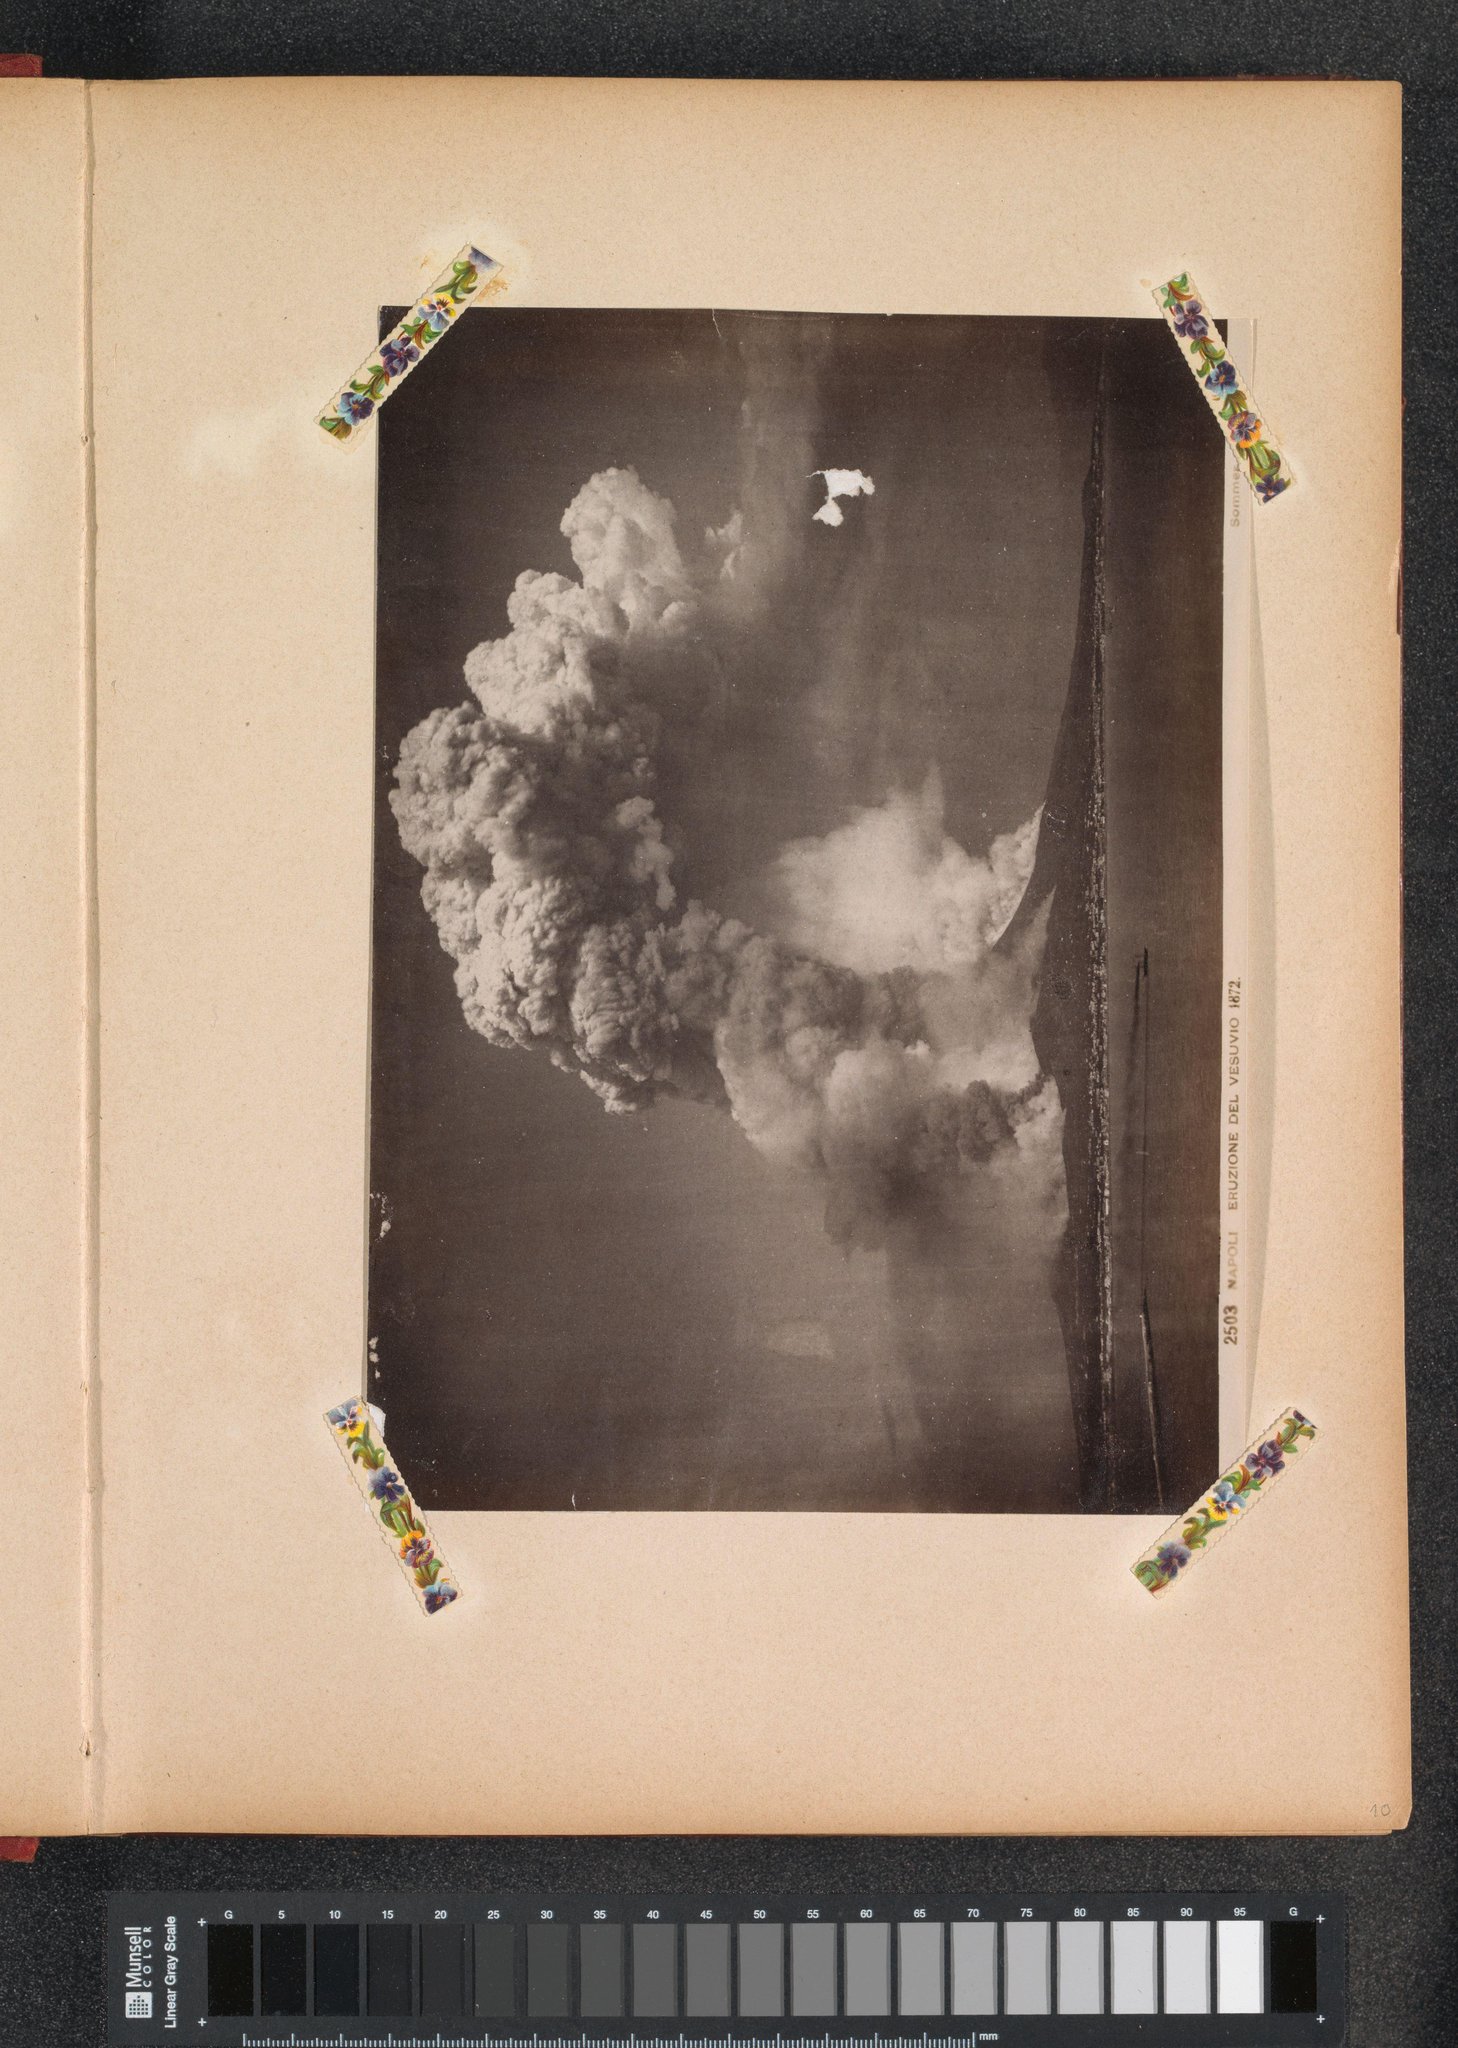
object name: photograph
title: Eruptie van de Vesuvius in 1872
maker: giorgio sommer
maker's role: fotograaf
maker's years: 1834-1914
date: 1872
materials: paper, photographic support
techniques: albumen print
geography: mount vesuvius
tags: volcano, eruption (of volcano), mount vesuvius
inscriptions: negative number: ‘2503’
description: Onderdeel van Reisalbum met foto's van bezienswaardigheden in Italië en Zuid-Frankrijk.